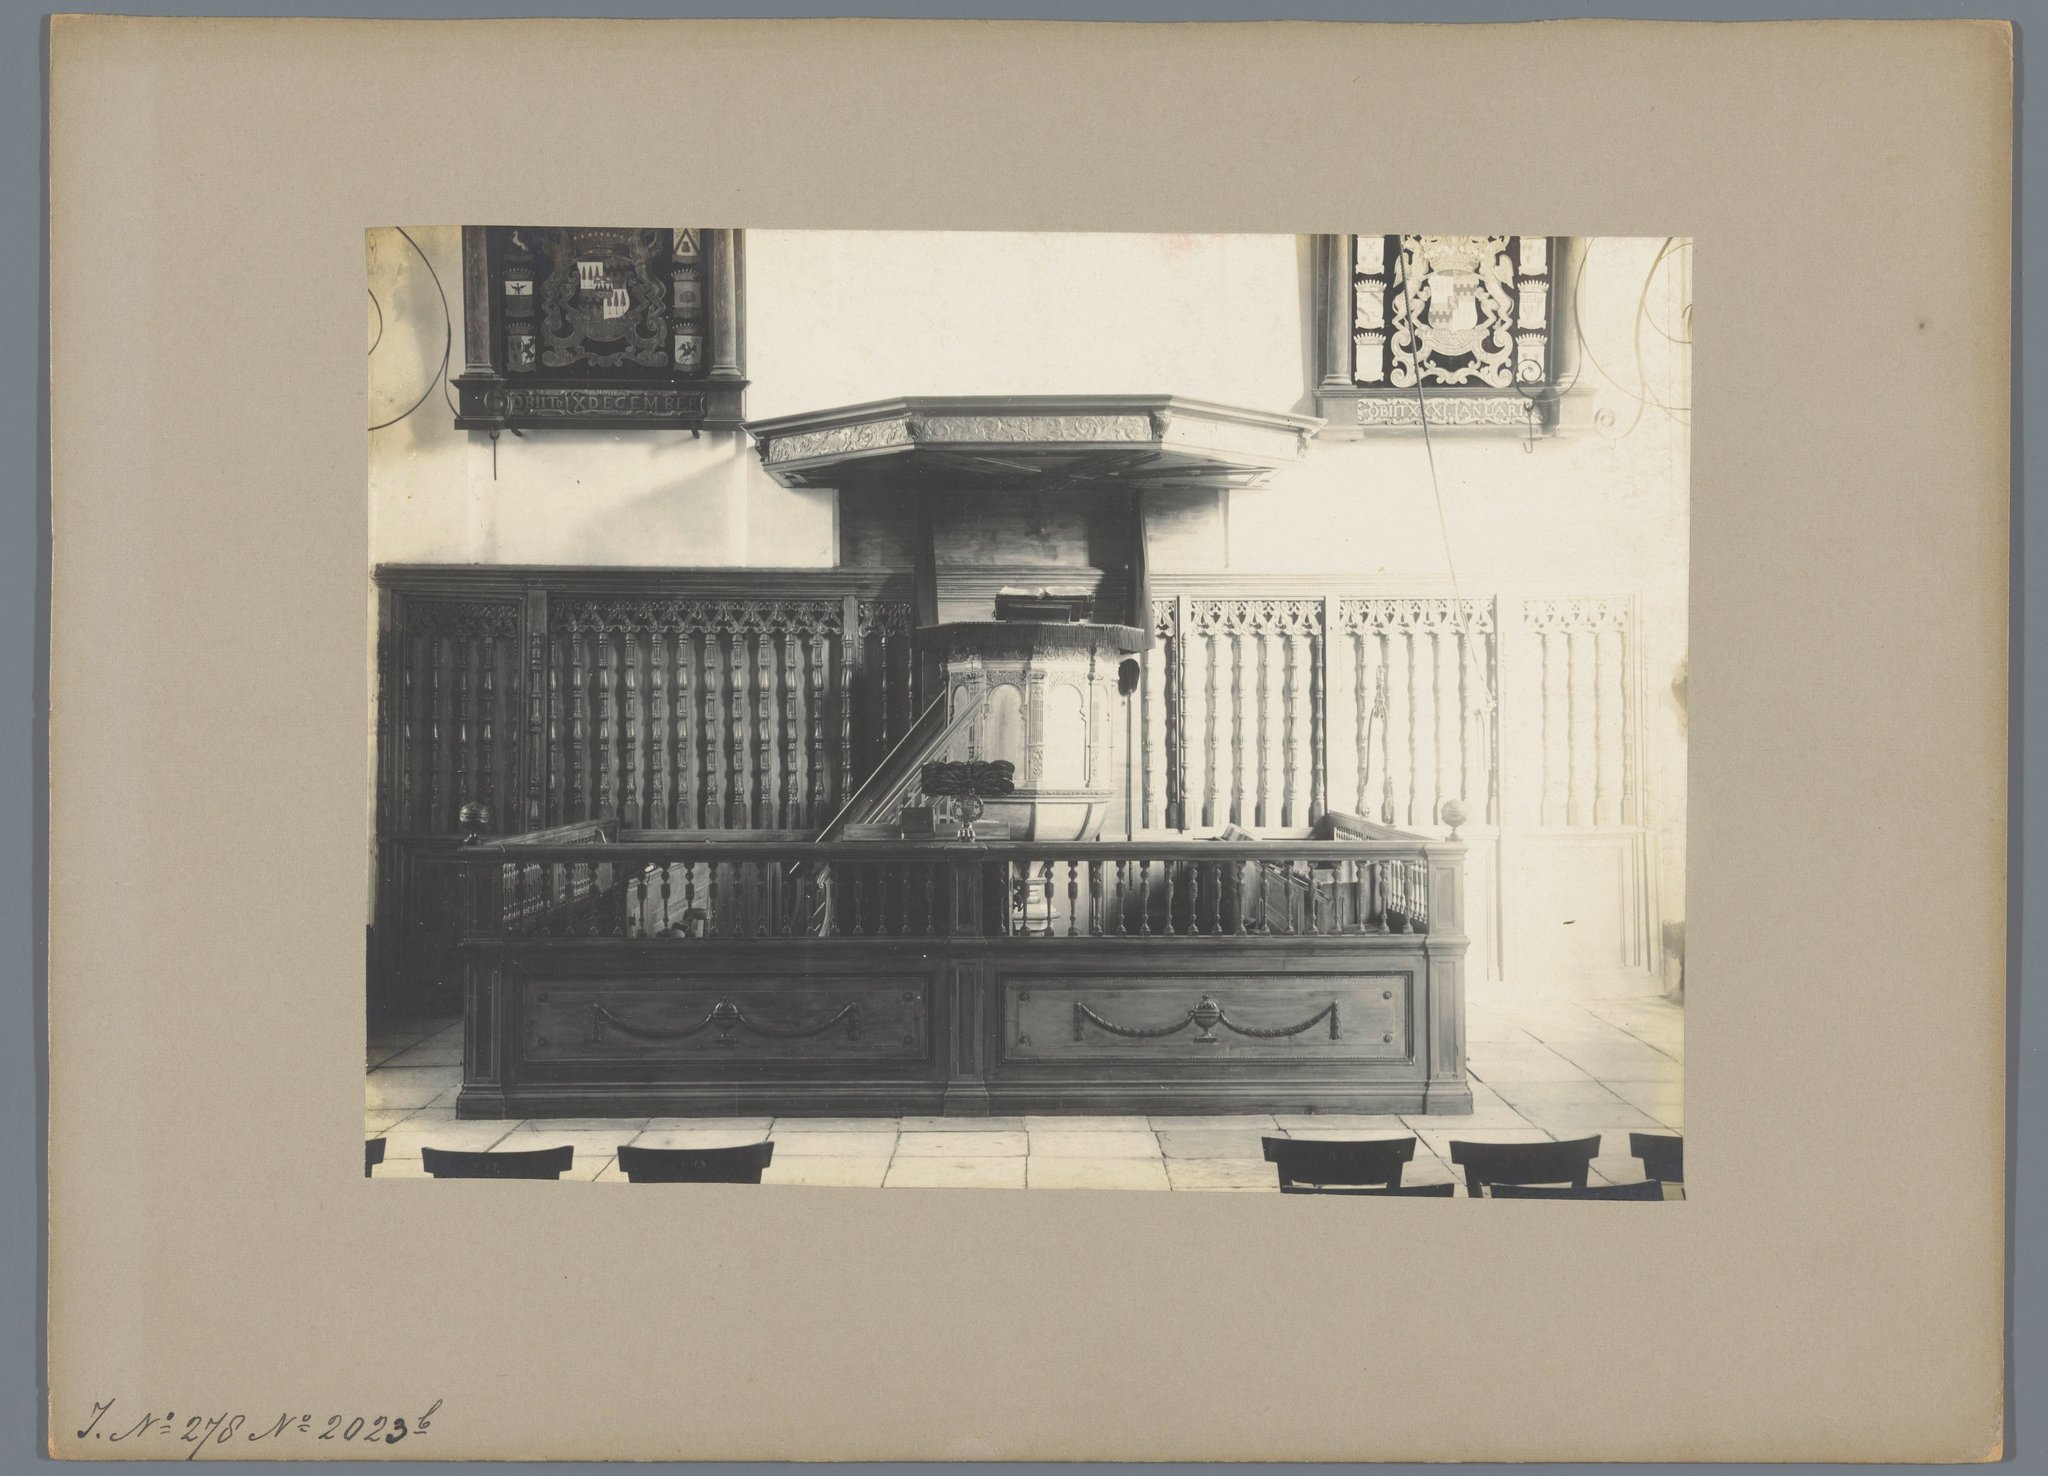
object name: photograph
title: Koorhek en de preekstoel in de Grote Kerk te Oosthuizen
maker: Anonymous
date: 1908-1910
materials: cardboard, photographic support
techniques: gelatin silver print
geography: grote kerk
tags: rood-screen, choir-screen; iconostasis, interior of church, pulpit, ambo, chancel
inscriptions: inscription: ‘Overgebleven gedeelte van het voormalige koorhek en preekstoel in de Ned. Herv. kerk te Oosthuizen. Aug. 1910 Oosthuizen en Hobrede. N-H.’, inscription: ‘neg. no 16718 foto 23765’, annotation